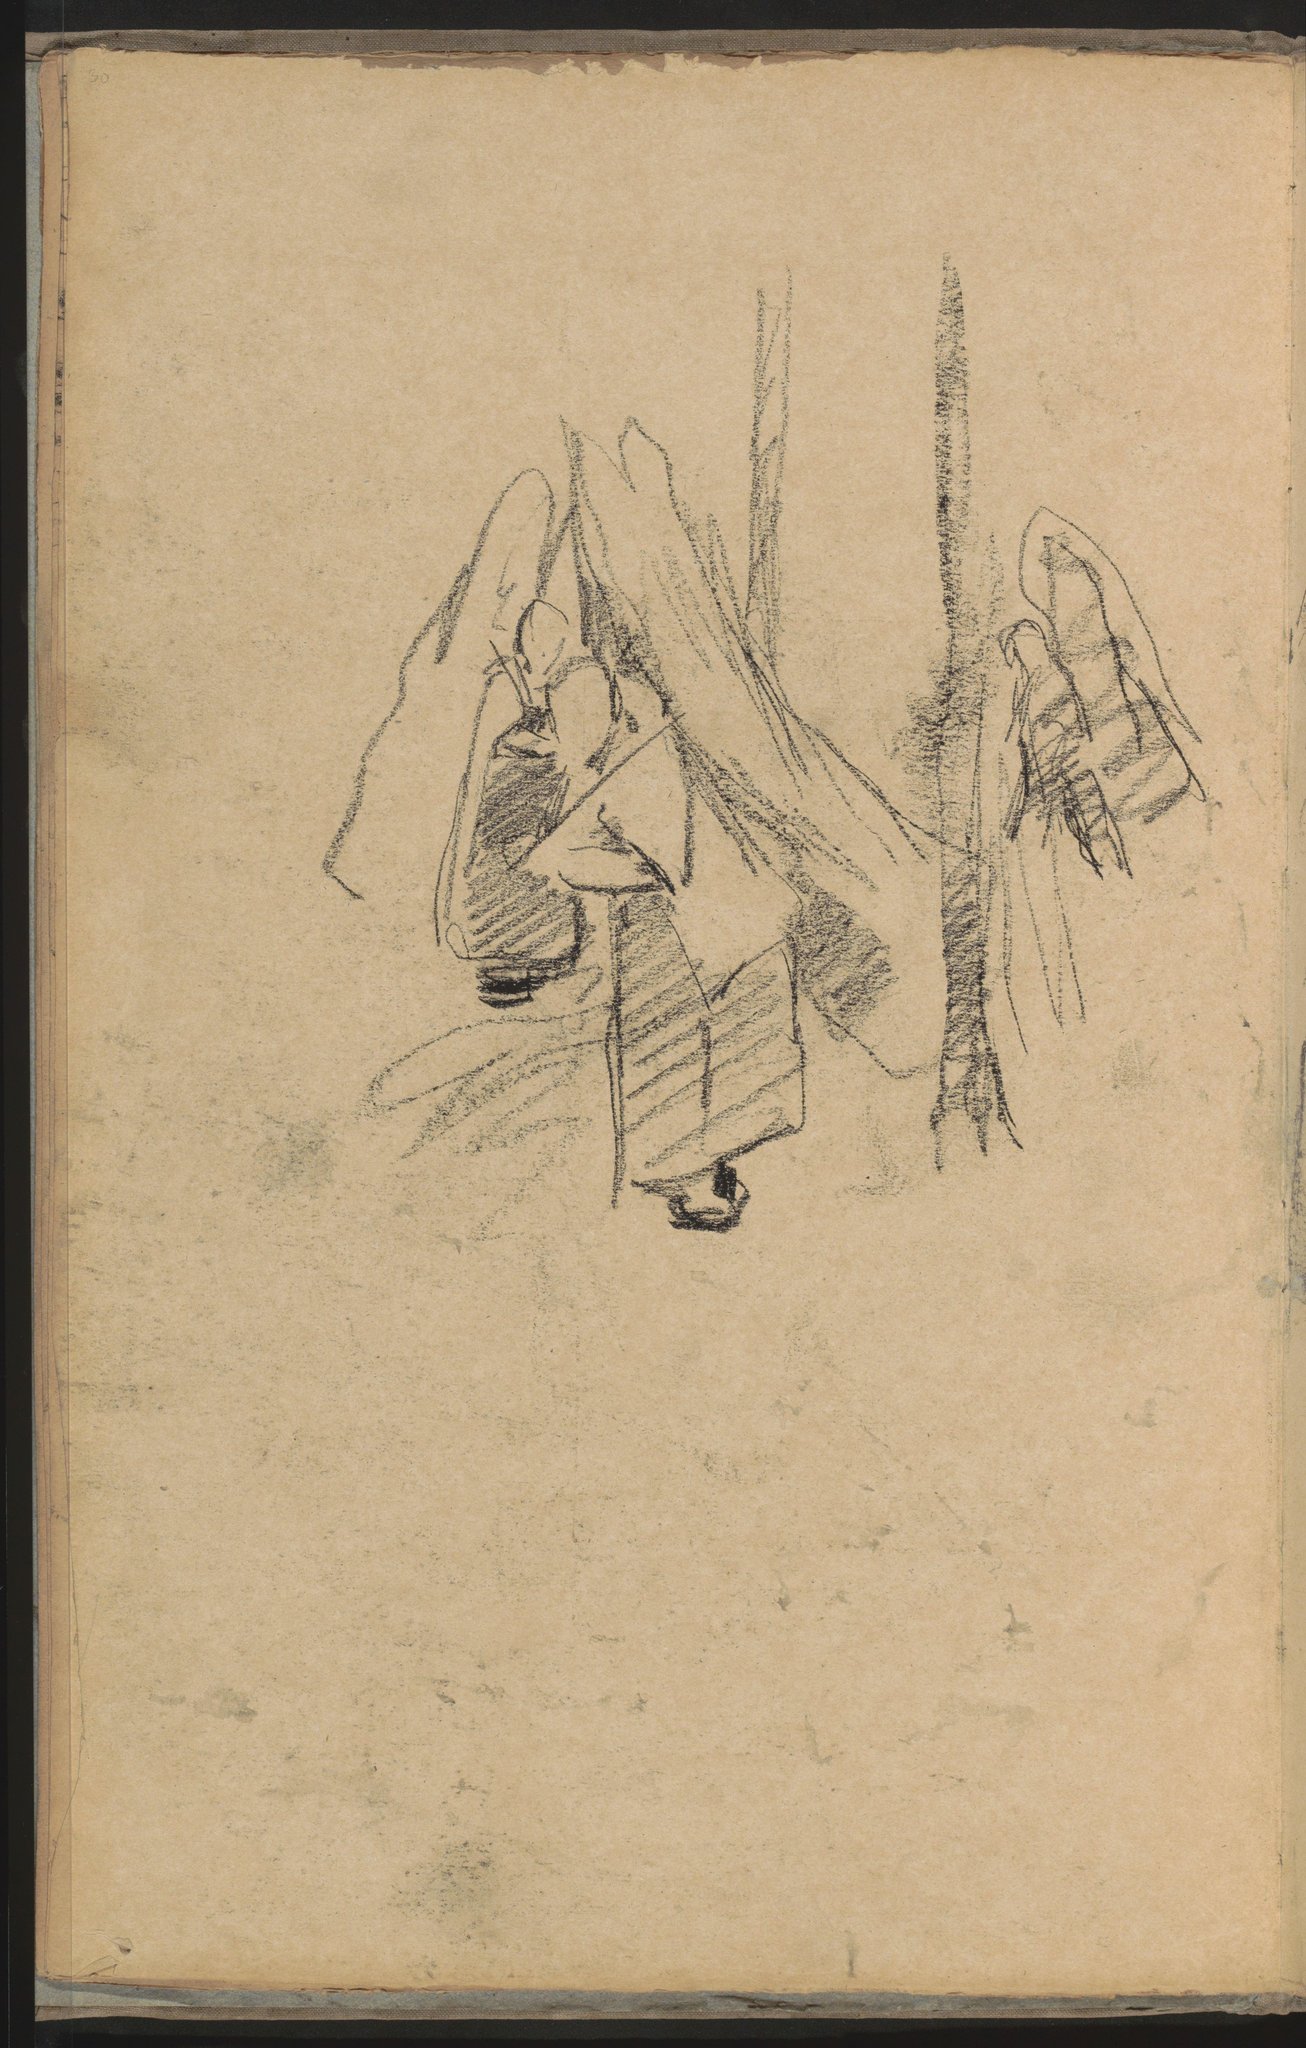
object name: sketchbook leaf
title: Jonge vrouwen met een takkenbossen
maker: willem witsen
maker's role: draughtsman, painter, print maker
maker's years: 1860-1923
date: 1884-1887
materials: chalk, paper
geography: ewijkshoeve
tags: trees (+ bundle of twigs, faggot), adolescent, young woman, maiden, woodgathering, woodgatherer, forest, wood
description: Houtsprokkelaarsters. Pagina 30 uit een schetsboek met 42 bladen vervaardigd rond de Ewijkshoeve.